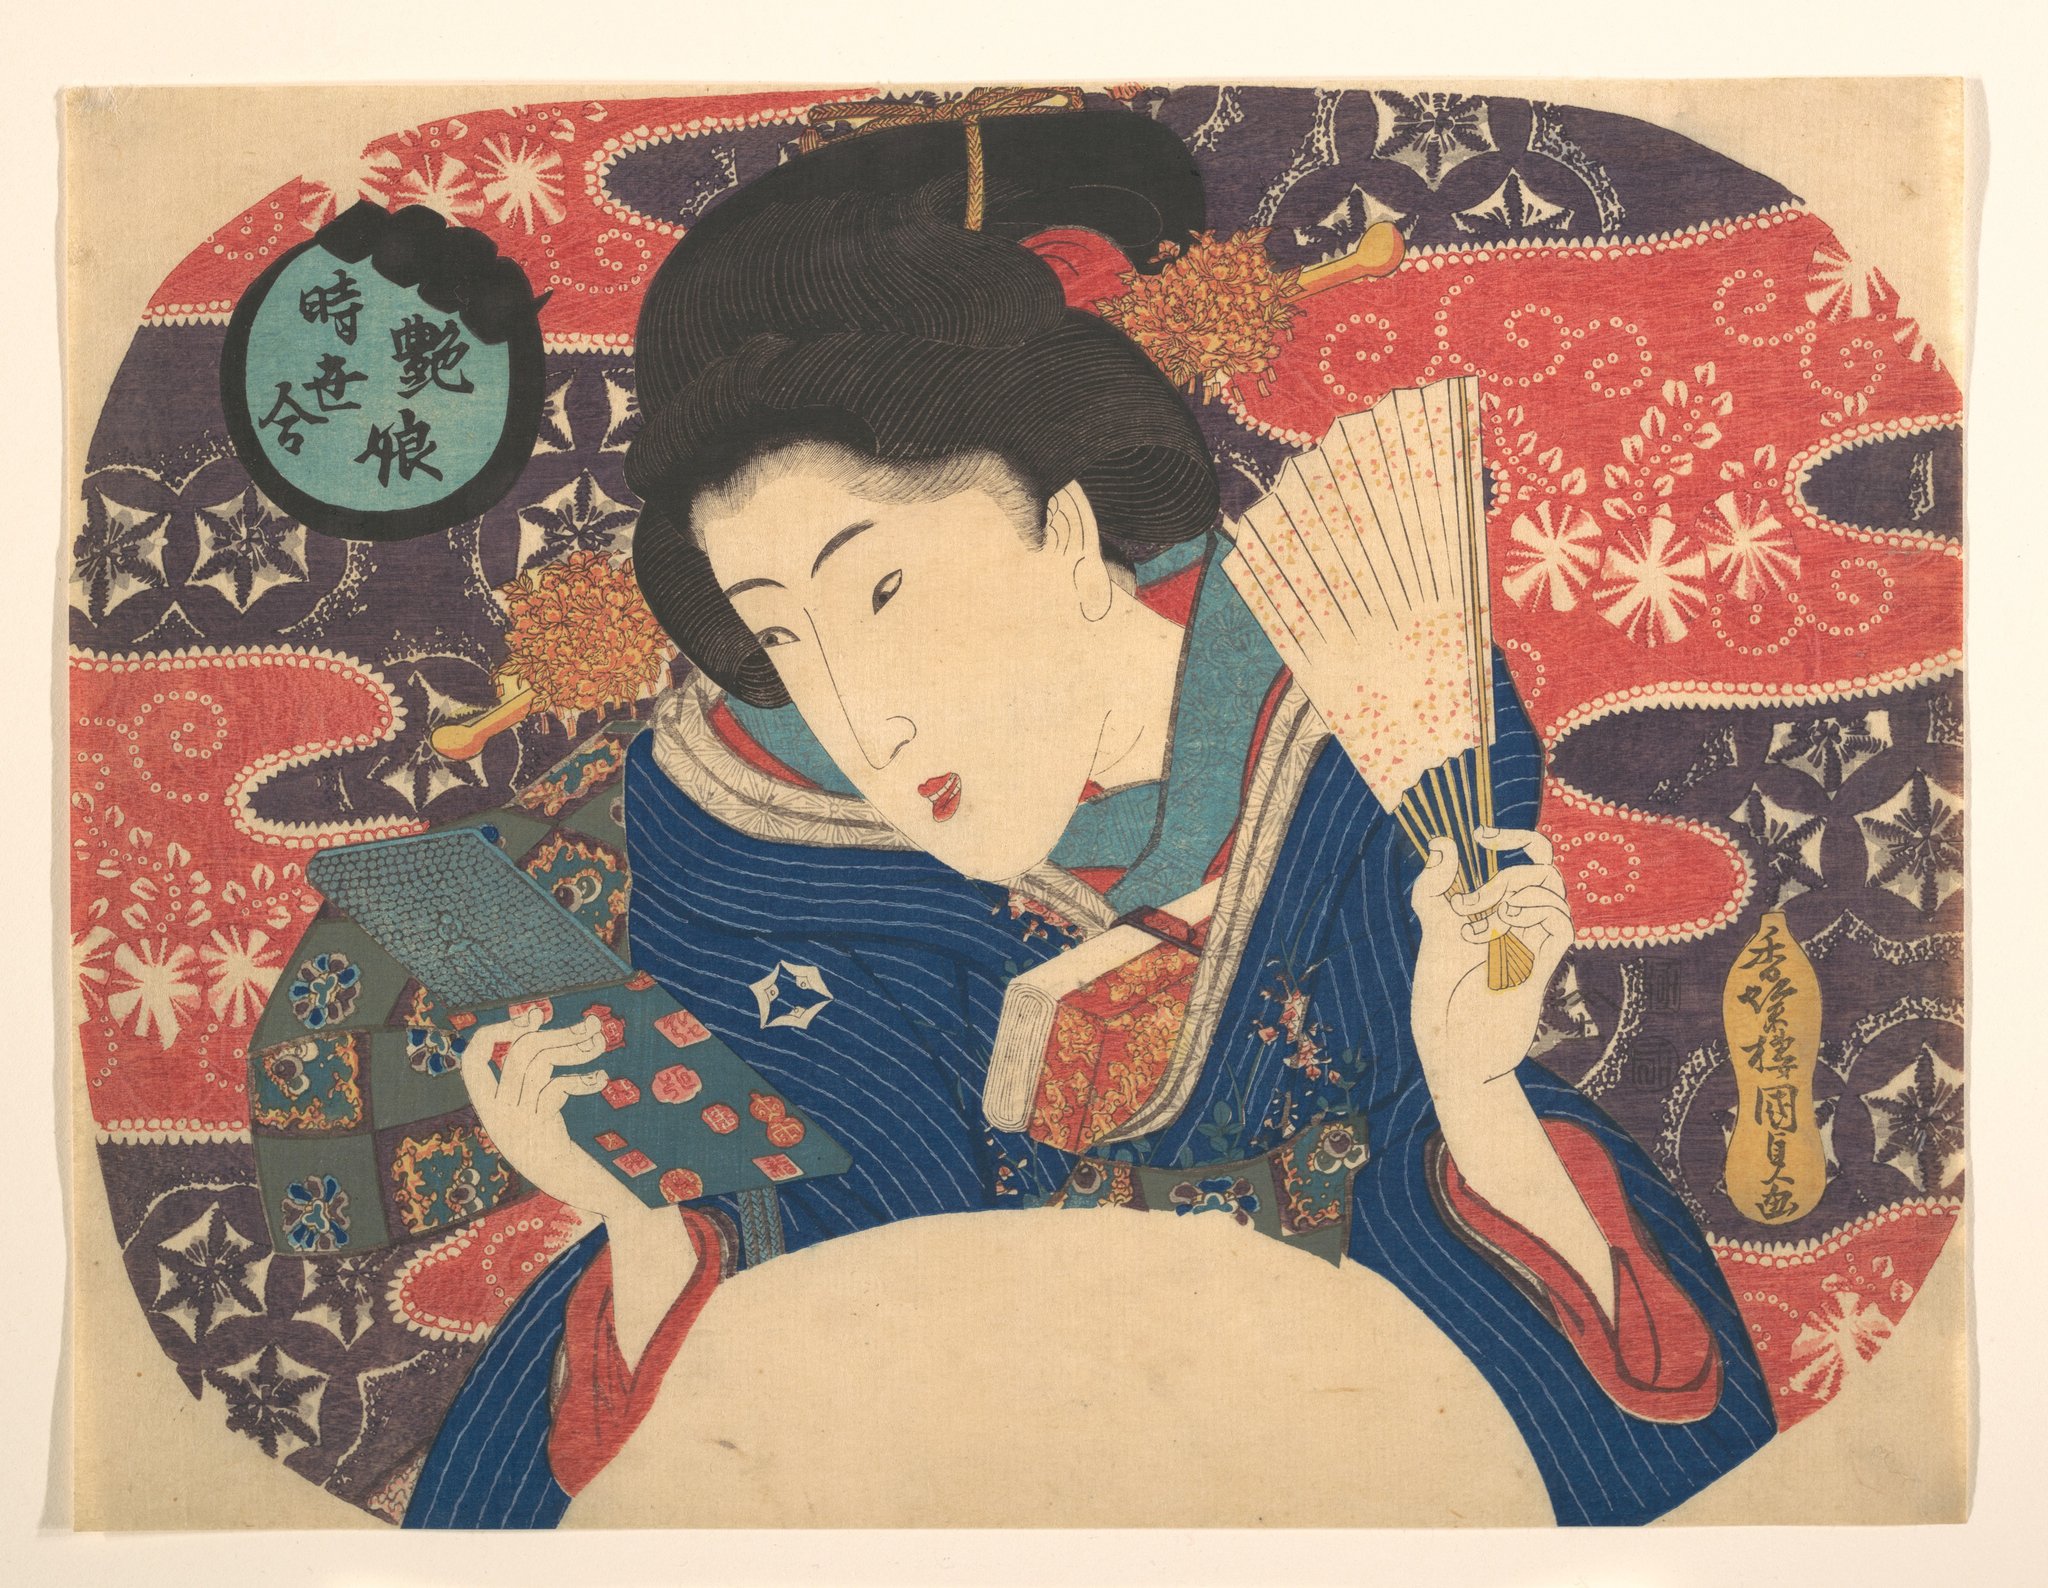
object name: print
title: Competition of Contemporary Fashions: Sexy Beauty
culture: japanese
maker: utagawa kunisada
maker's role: artist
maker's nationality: japanese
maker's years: 1786-1864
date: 1801-1900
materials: ink, paper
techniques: woodblock print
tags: fans,women